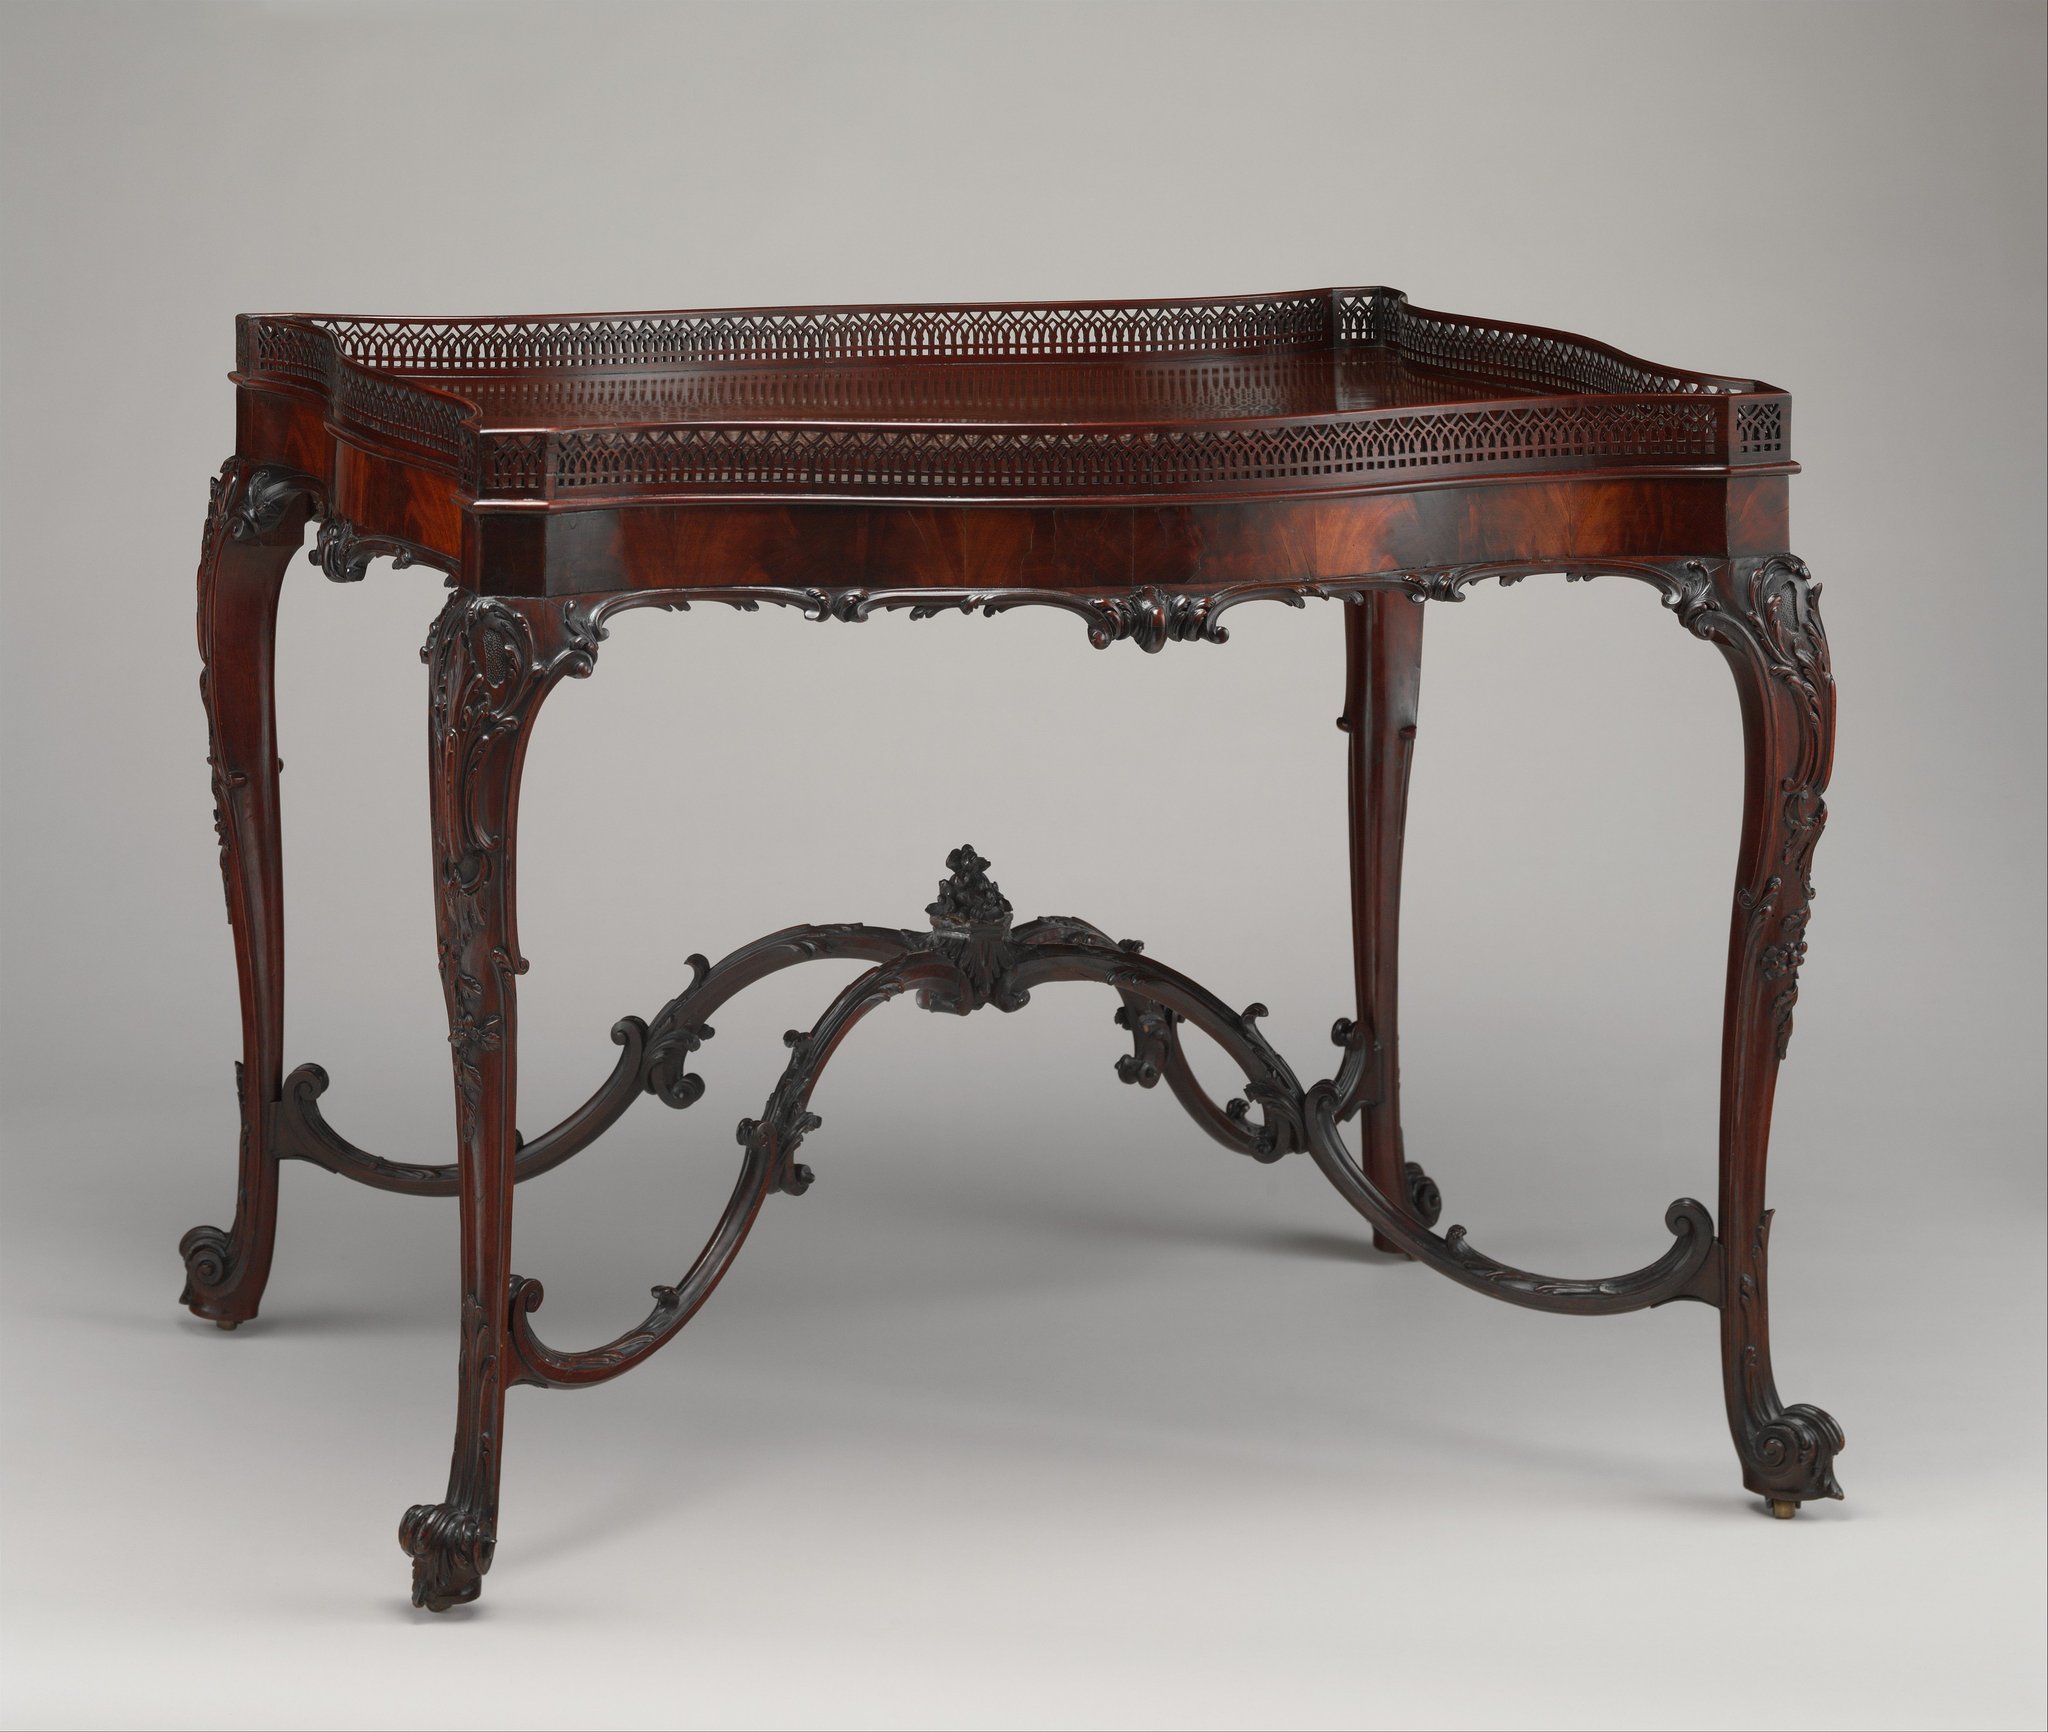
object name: china table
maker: thomas chippendale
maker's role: designer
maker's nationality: british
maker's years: 1718-1779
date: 1755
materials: wood